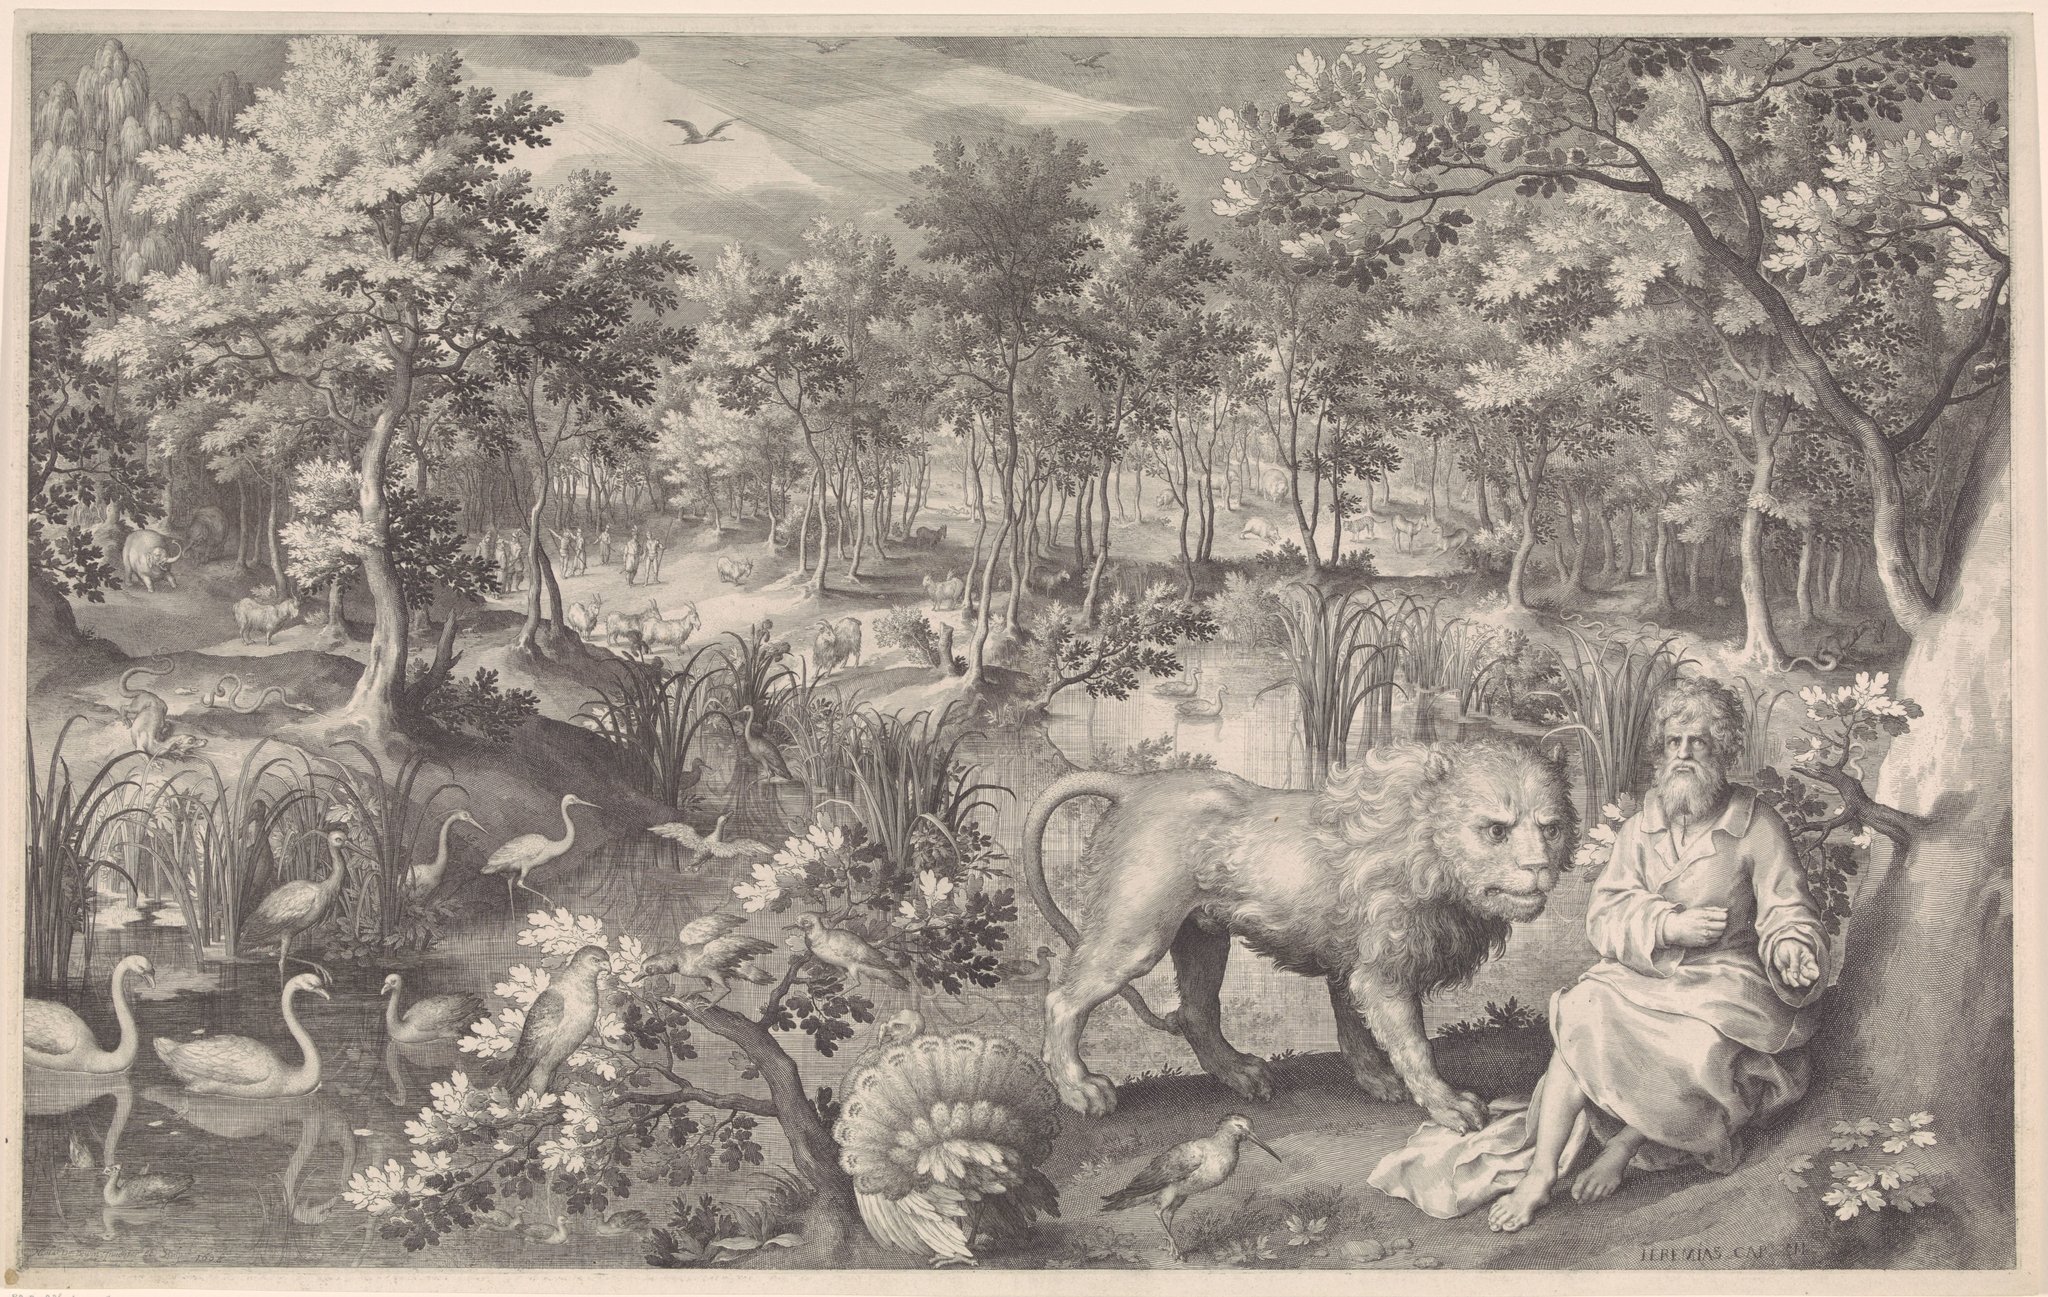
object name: print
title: Jeremia in de wildernis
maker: nicolaes de bruyn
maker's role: print maker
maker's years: 1571-1656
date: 1608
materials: paper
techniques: engraving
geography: antwerp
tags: other scenes ~ the book of jeremiah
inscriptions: collector's mark: Lugt 2228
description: De profeet Jeremia in de wildernis. Rondom hem verschillende wilde dieren, waaronder een leeuw. Een onderschrift bij de prent verwijst naar de profetie van Jeremia 12.